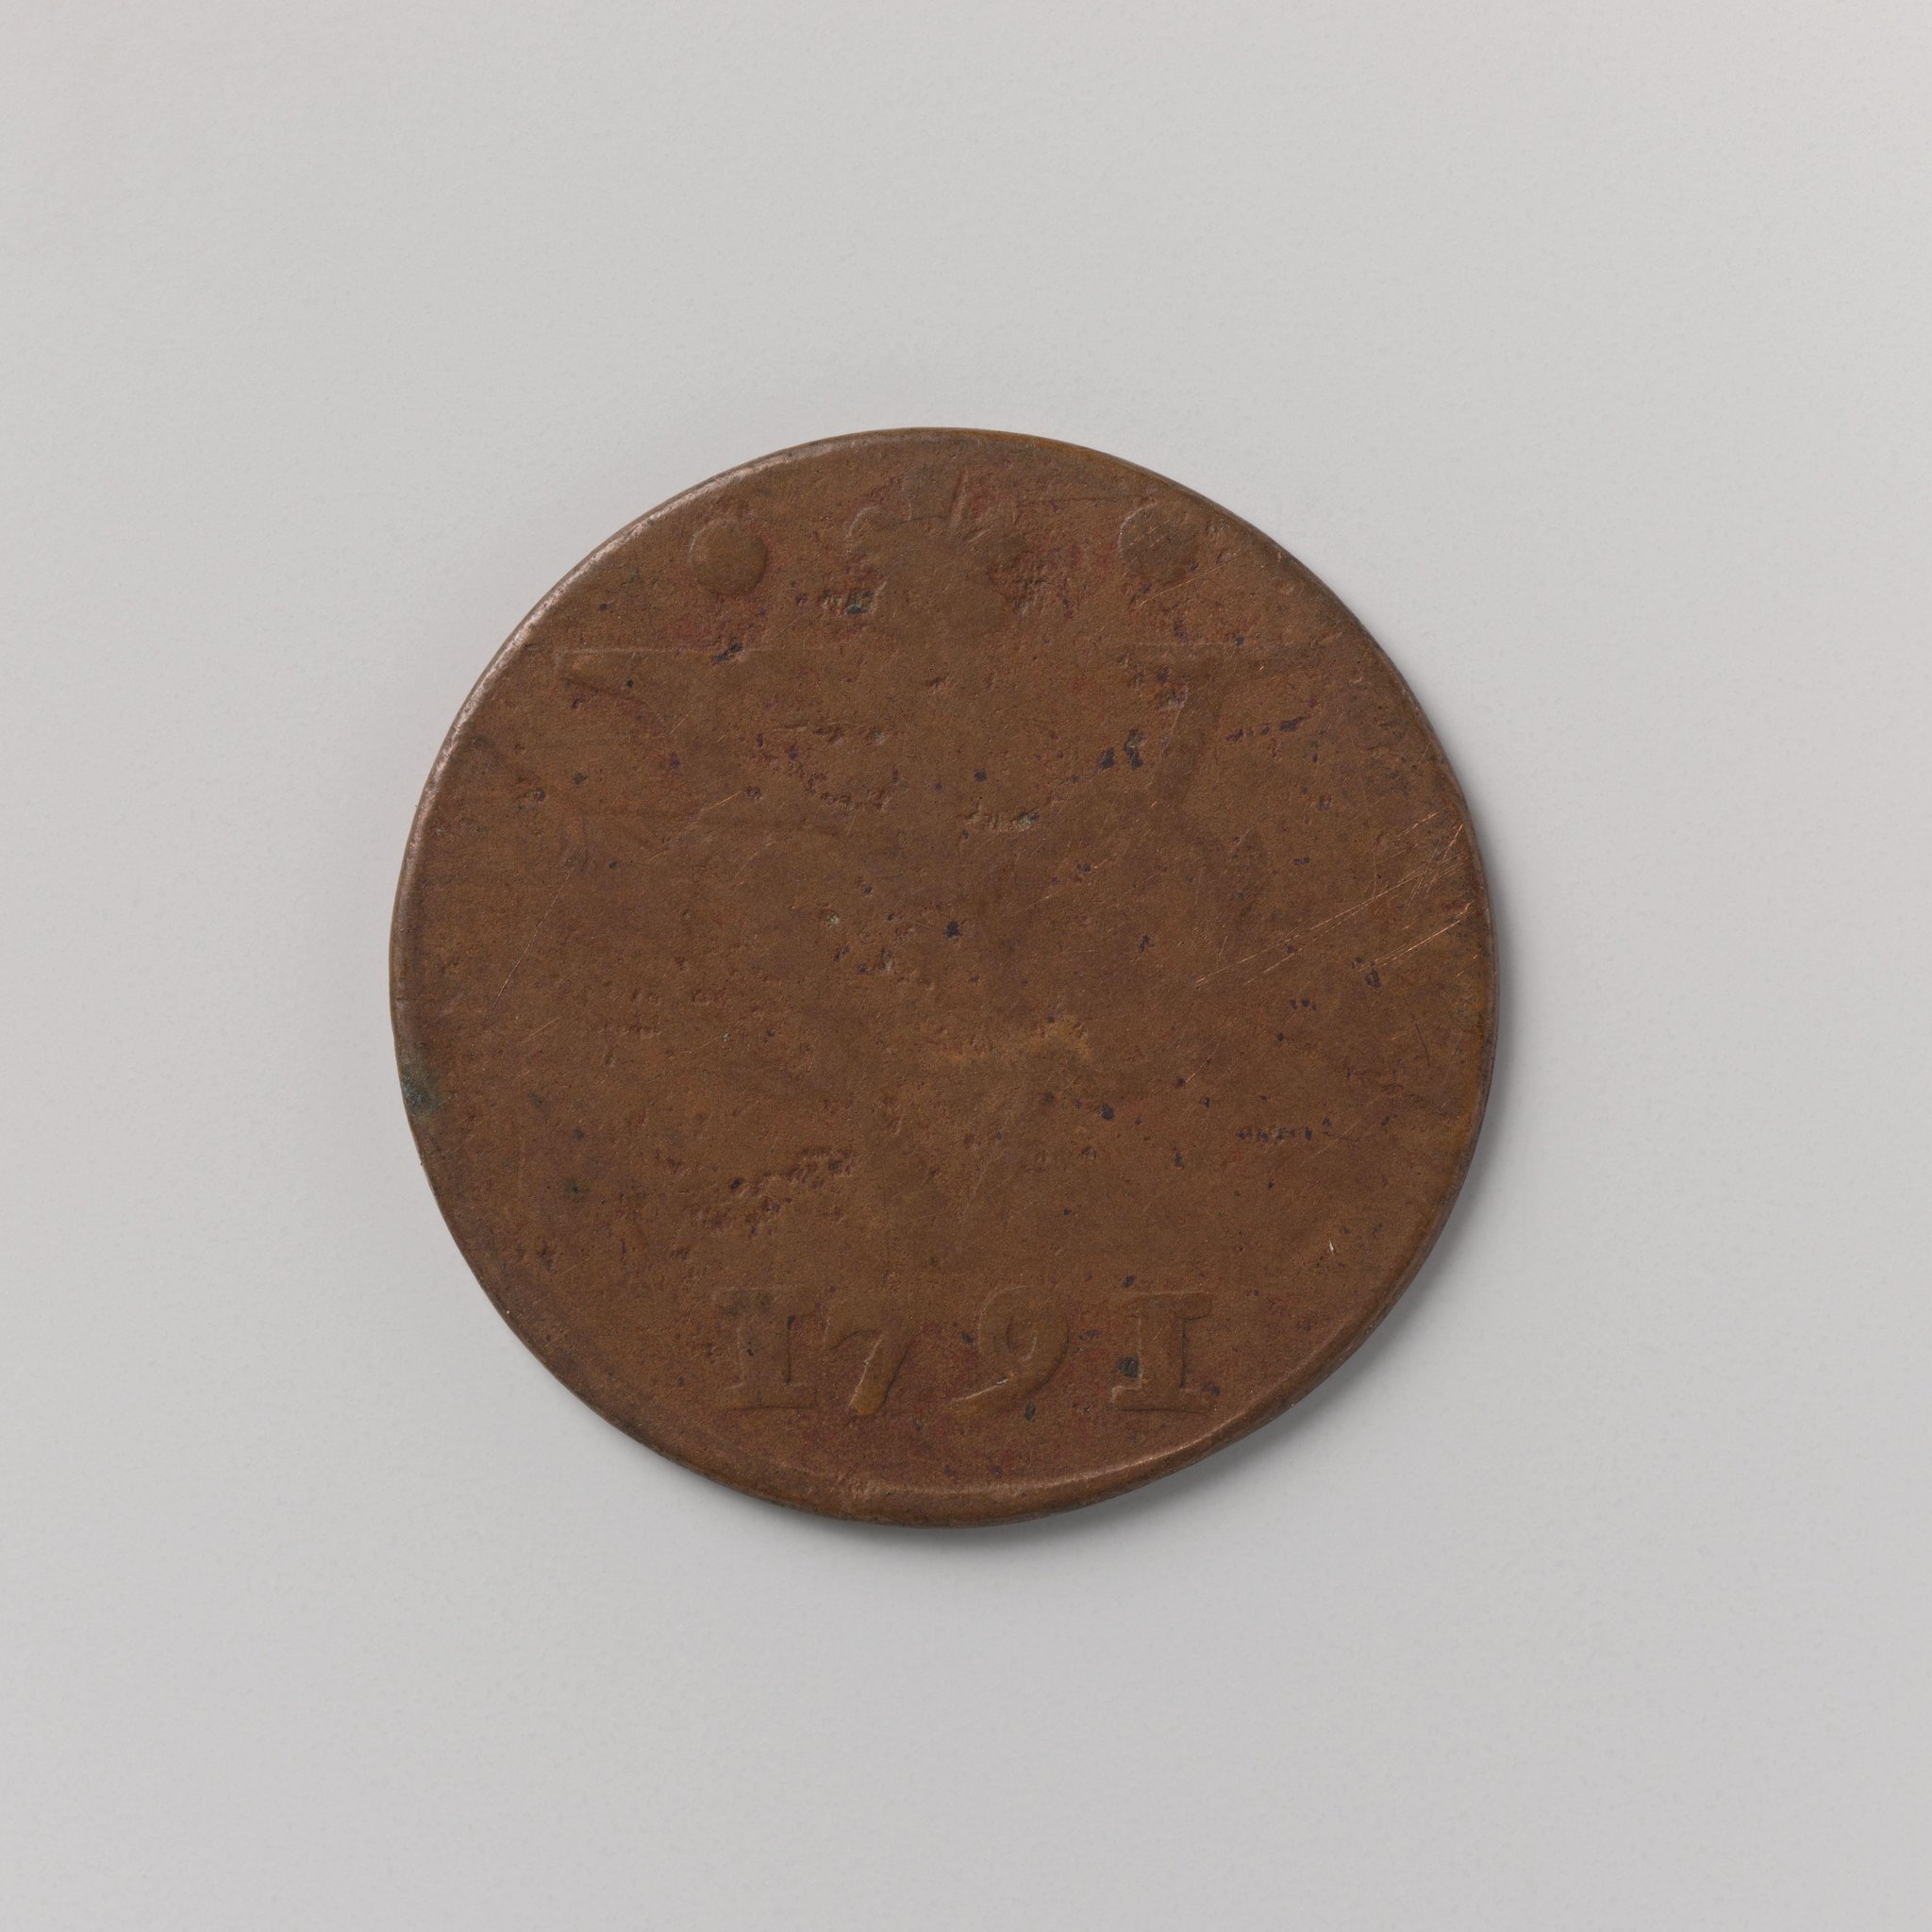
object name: coin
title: Duit van de VOC uit Holland, 1791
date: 1791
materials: copper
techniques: striking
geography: dordrecht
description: Koperen munt. Voorzijde: gekroond wapenschild van Holland. Keerzijde: monogram van de VOC, waarboven muntteken en waaronder jaartal. Gladde rand.